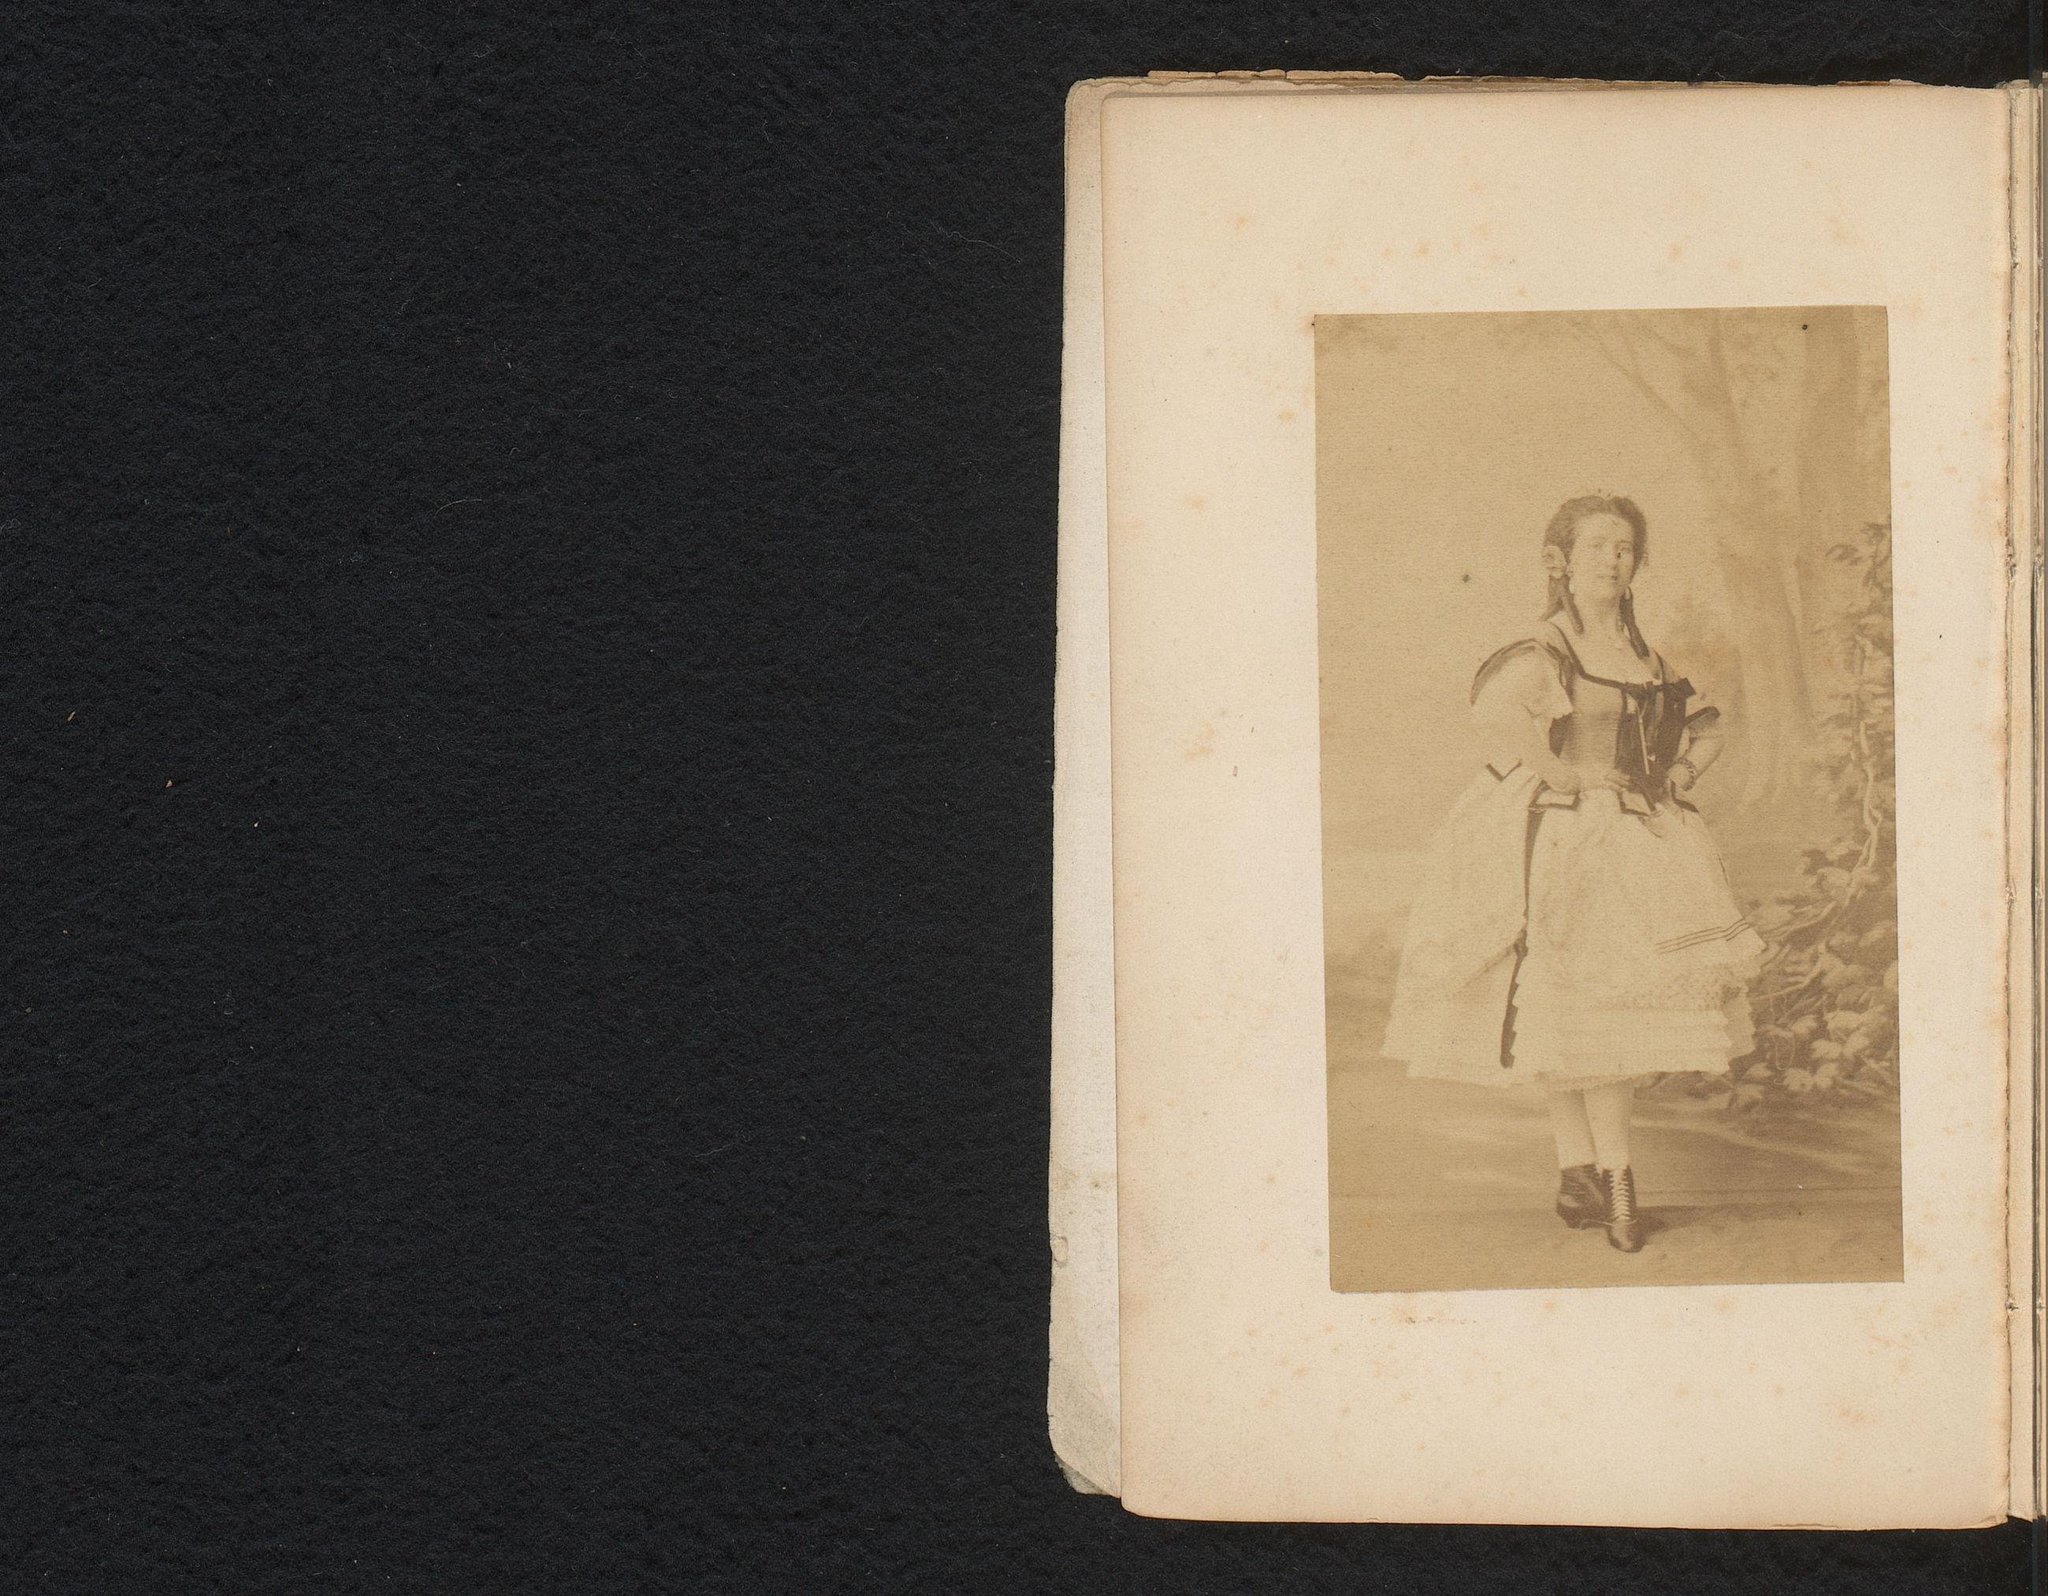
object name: page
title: Portret van een onbekende Franse danseres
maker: Anonymous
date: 1859-1864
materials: paper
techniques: albumen print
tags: historical persons not known by name - bb - woman, female dancer